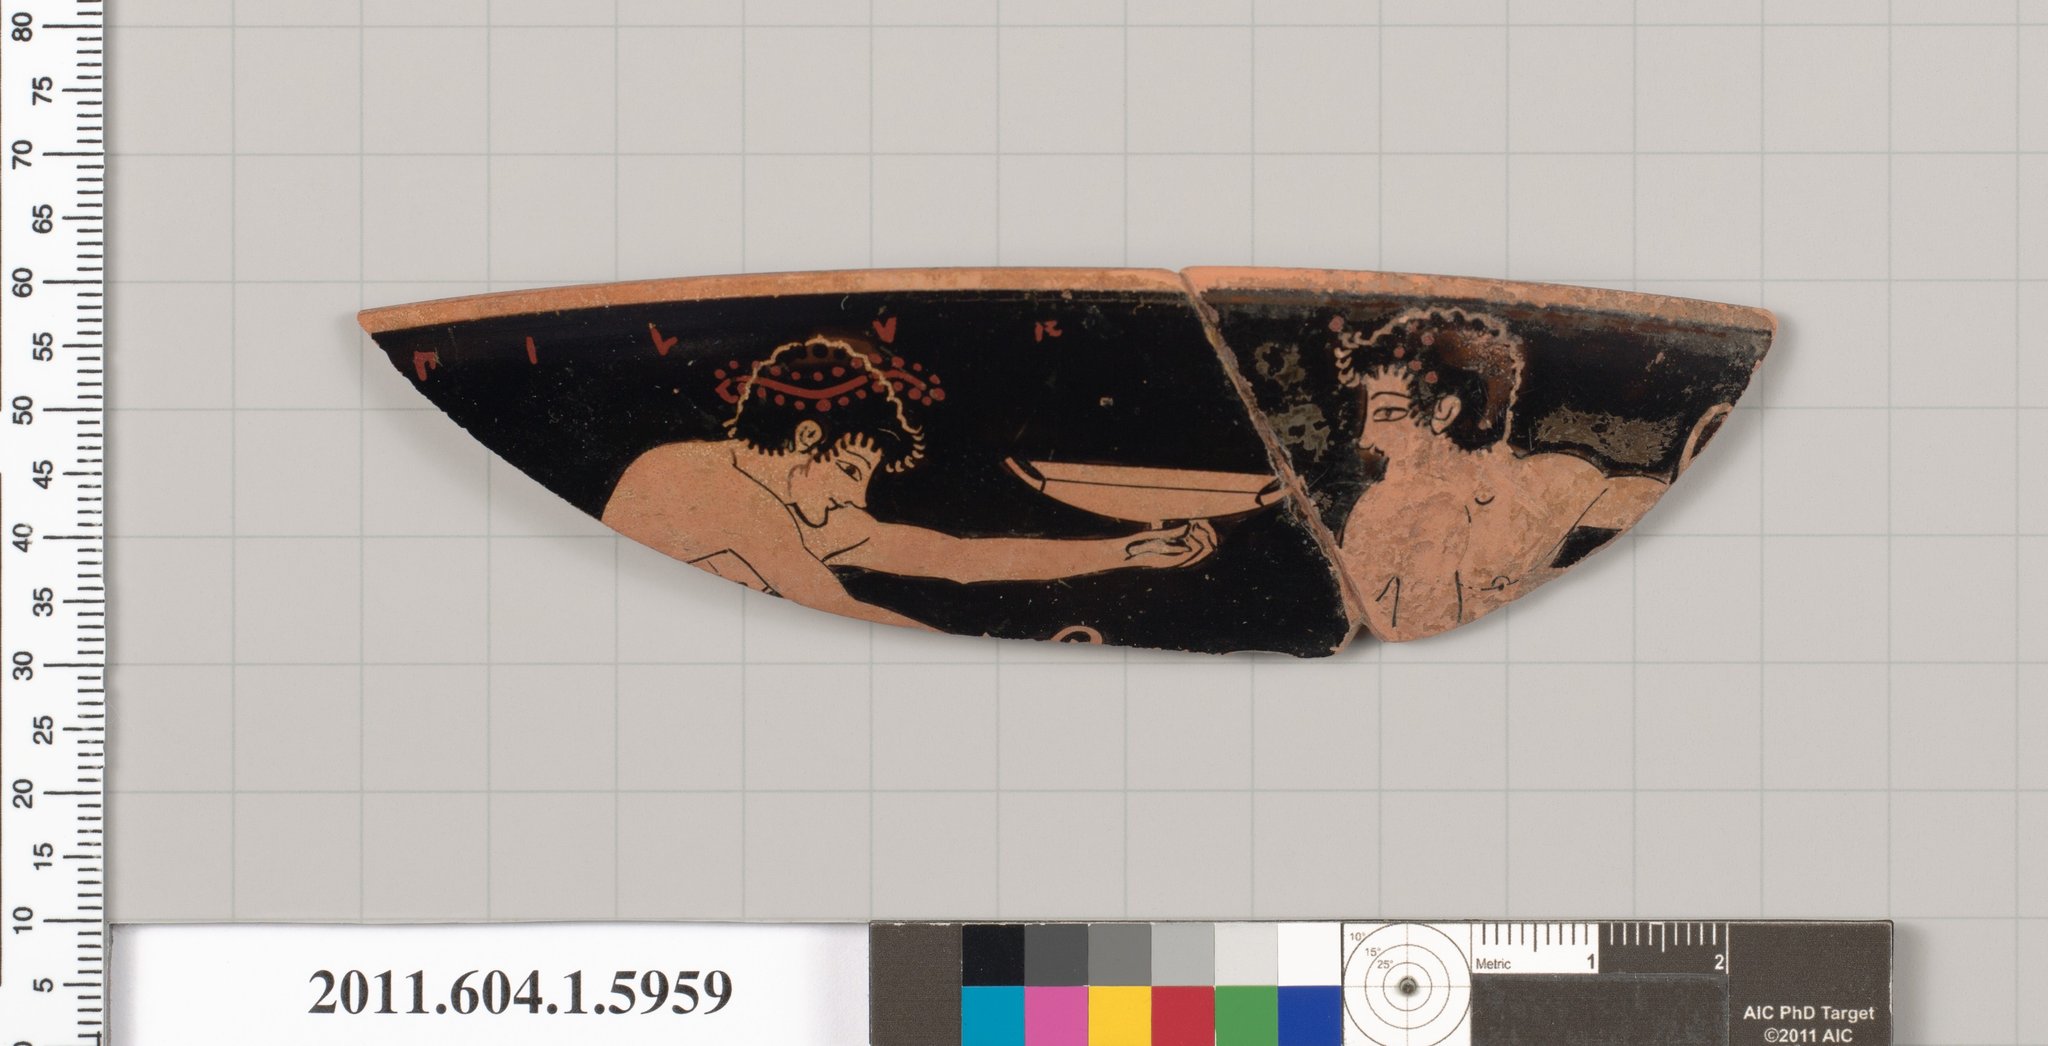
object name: kylix fragment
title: Terracotta rim fragment of a kylix (drinking cup)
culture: greek, attic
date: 433-567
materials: terracotta